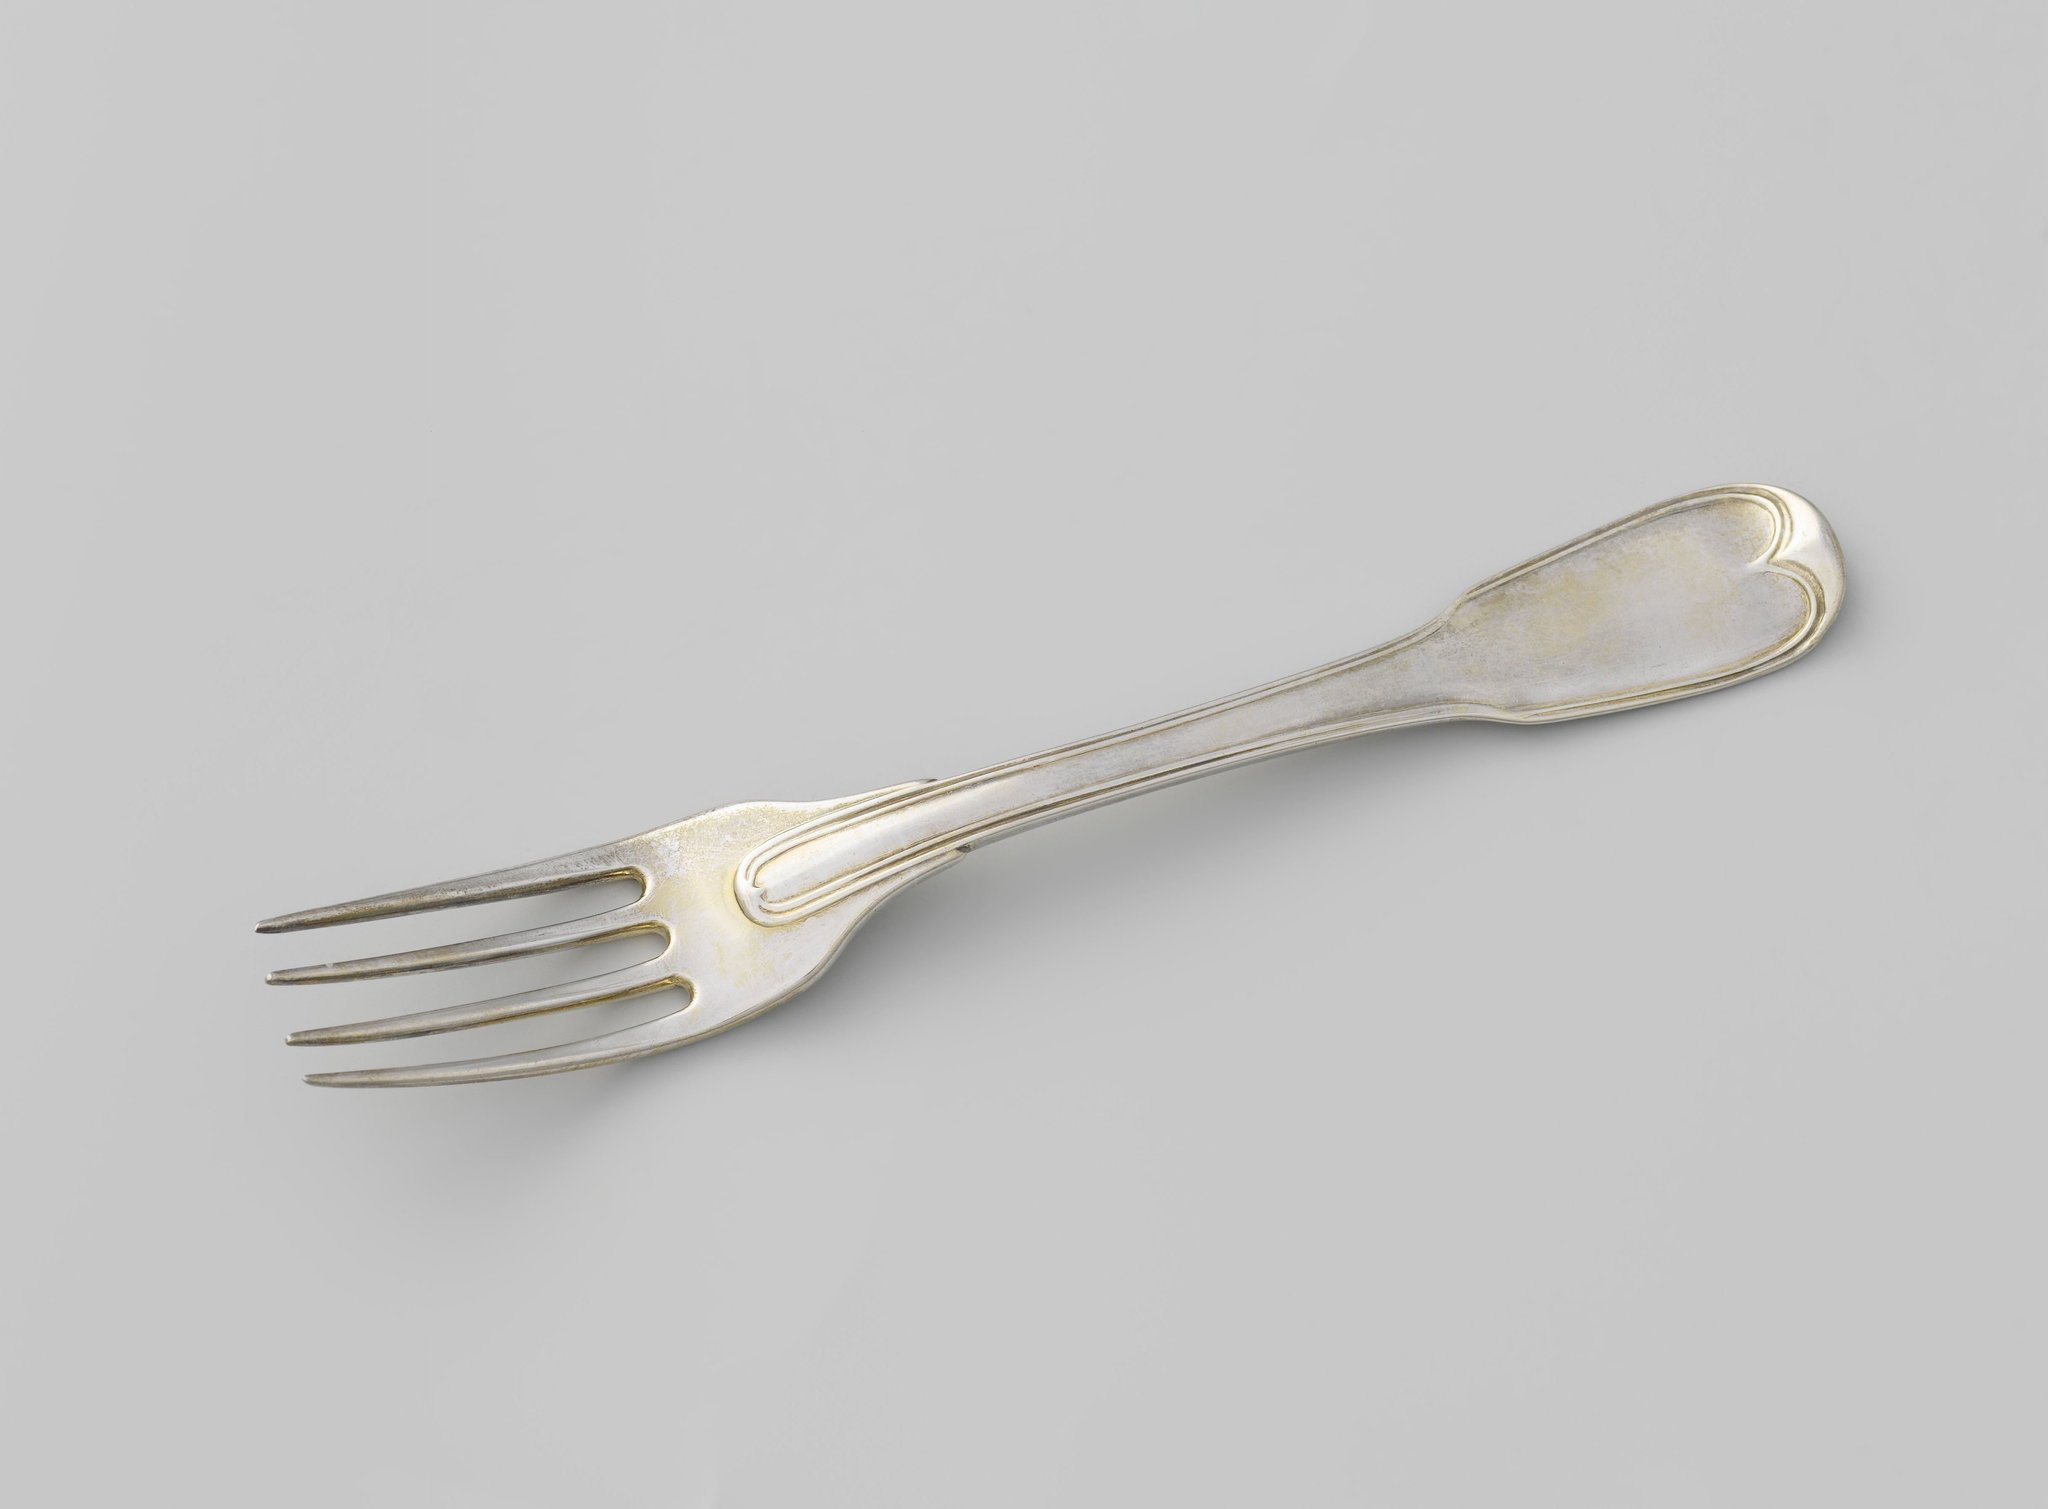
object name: fork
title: Vork met het helmteken Clifford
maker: roelof helweg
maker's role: silversmith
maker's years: 1758-1843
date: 1806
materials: silver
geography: amsterdam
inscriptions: date letter: ‘X (=1806)’, town mark: ‘Amsterdam’, alloy mark: ‘Hollandse leeuw’, maker's mark: ‘RH in ovaal’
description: De viertandige vork is aan zowel boven- als onderzijde door middel van enkel lof verbonden met de platte, gebogen steel, die zich verbreedt naar het spatelvormige uiteinde. Boven- en onderzijde van de steel worden omgeven door een dubbele filetrand, die bij het uiteinde ingezwenkt is. Op de onderzijde van de spatel is het helmteken Clifford gegraveerd.